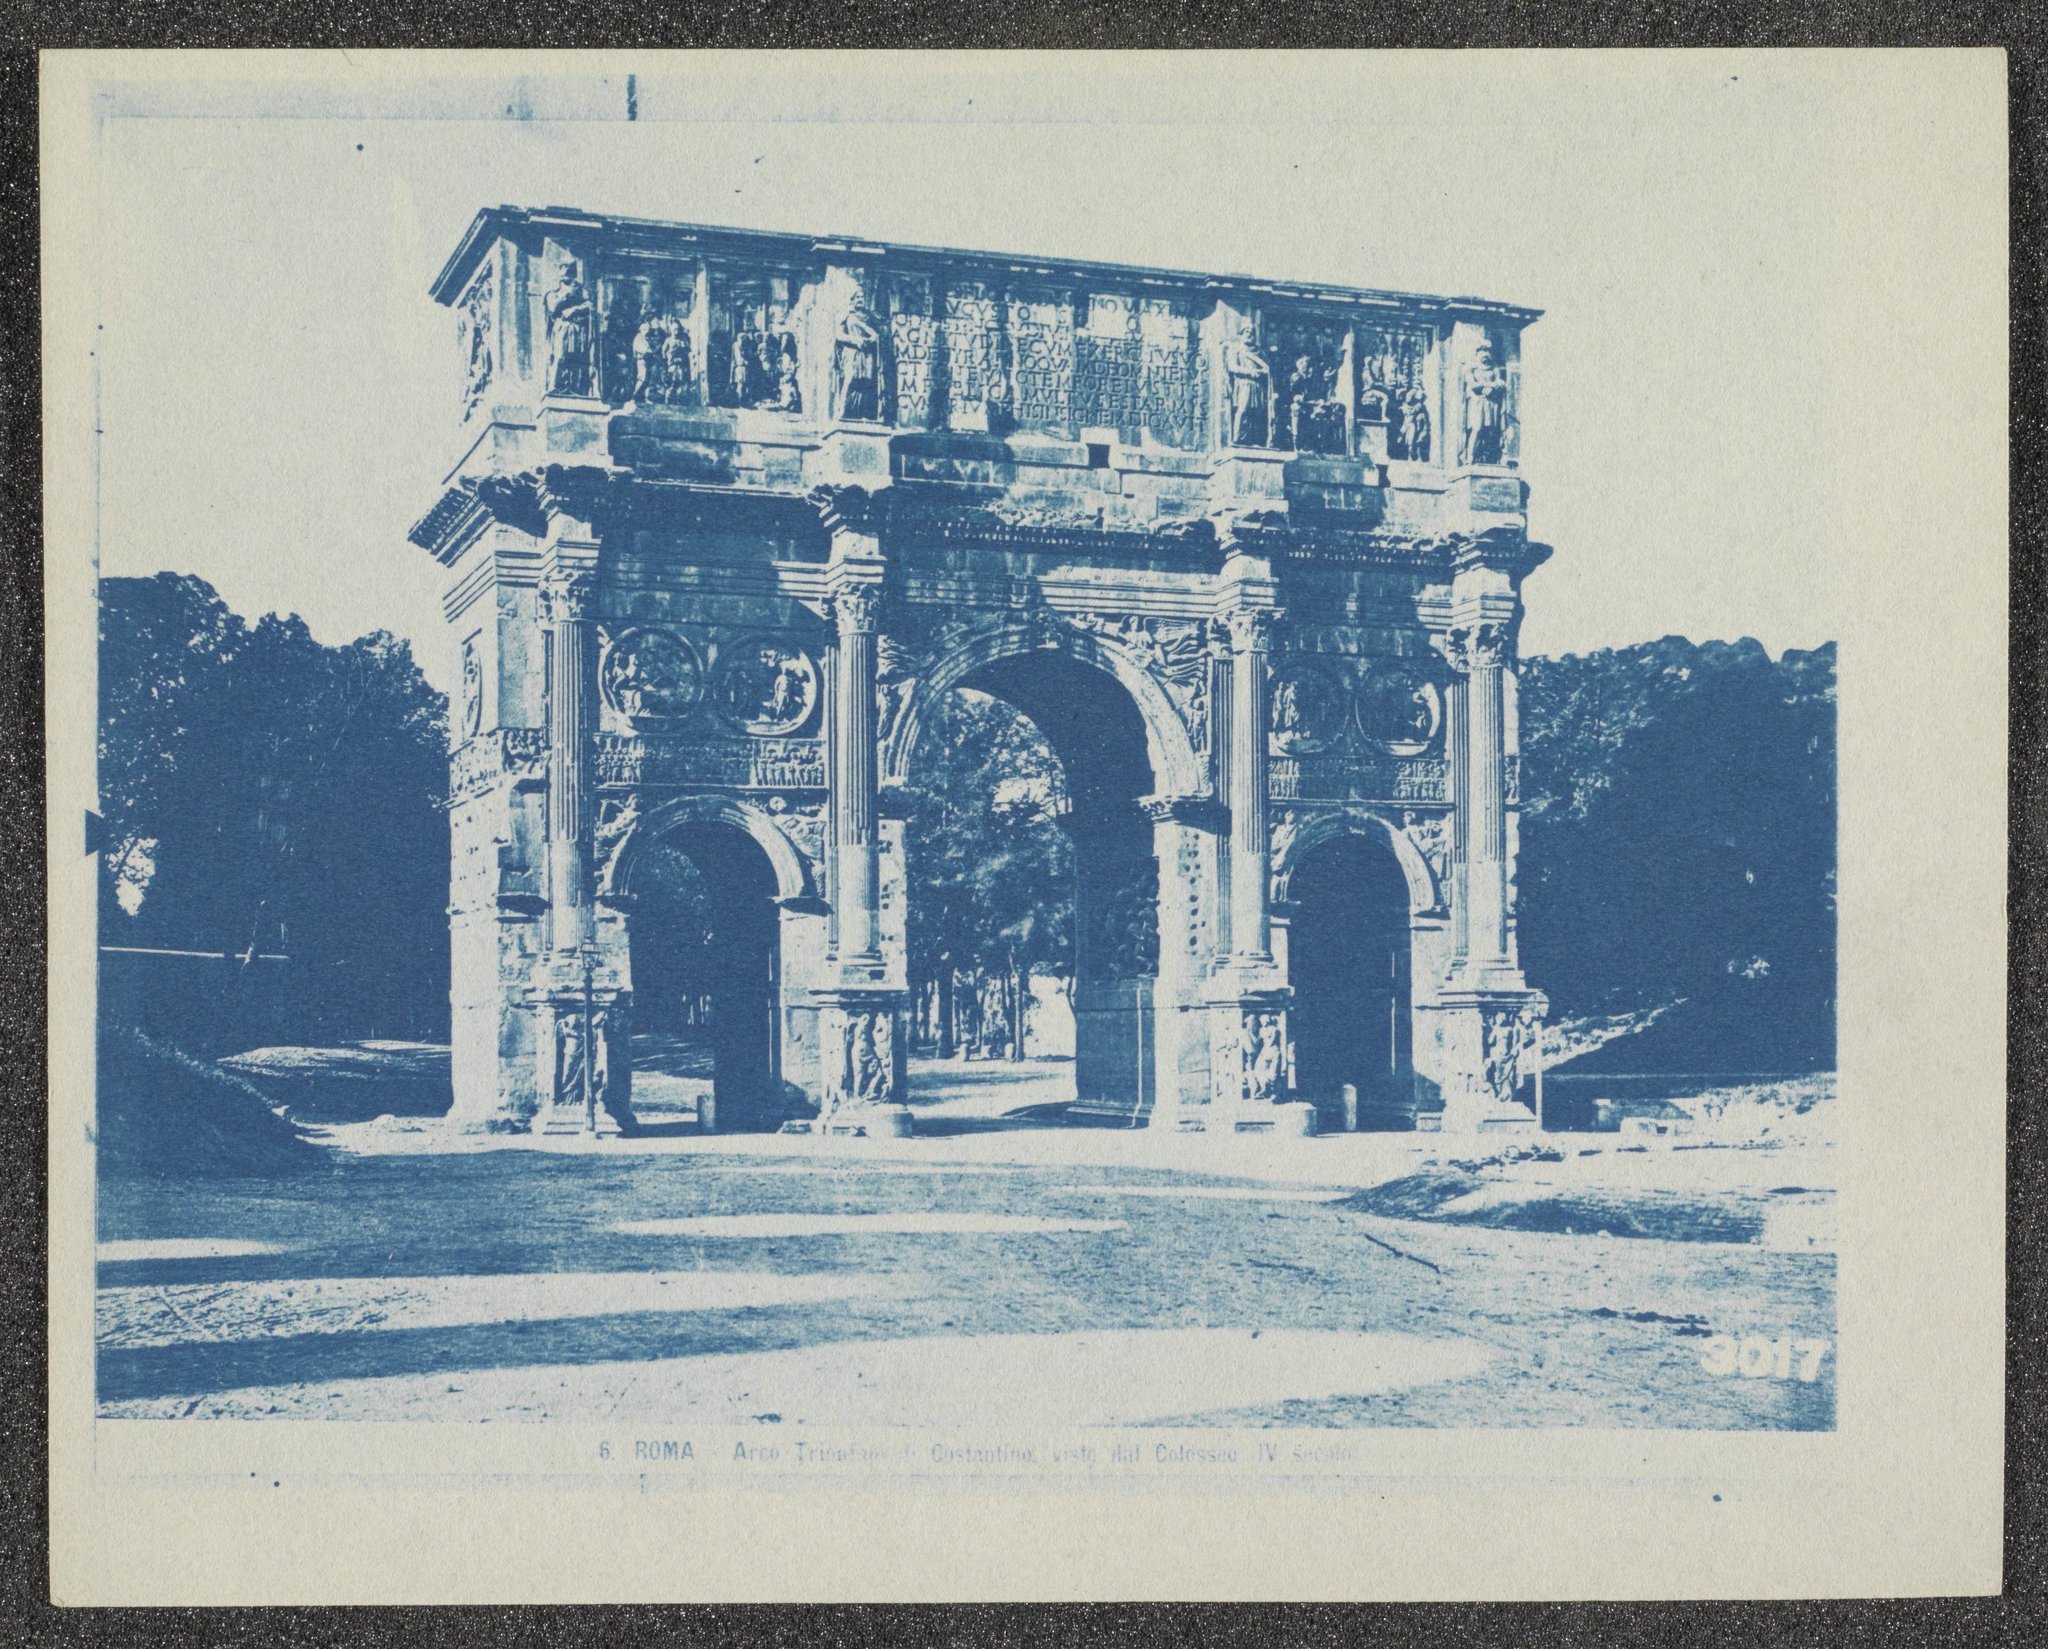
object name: photograph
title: Fotoreproductie van een foto van de Boog van Constantijn te Rome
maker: Anonymous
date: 1880-1905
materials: paper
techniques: cyanotype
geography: rome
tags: triumphal arch, arch of constantine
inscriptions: number: ‘3017’, inscription: ‘Arch of Constantine’